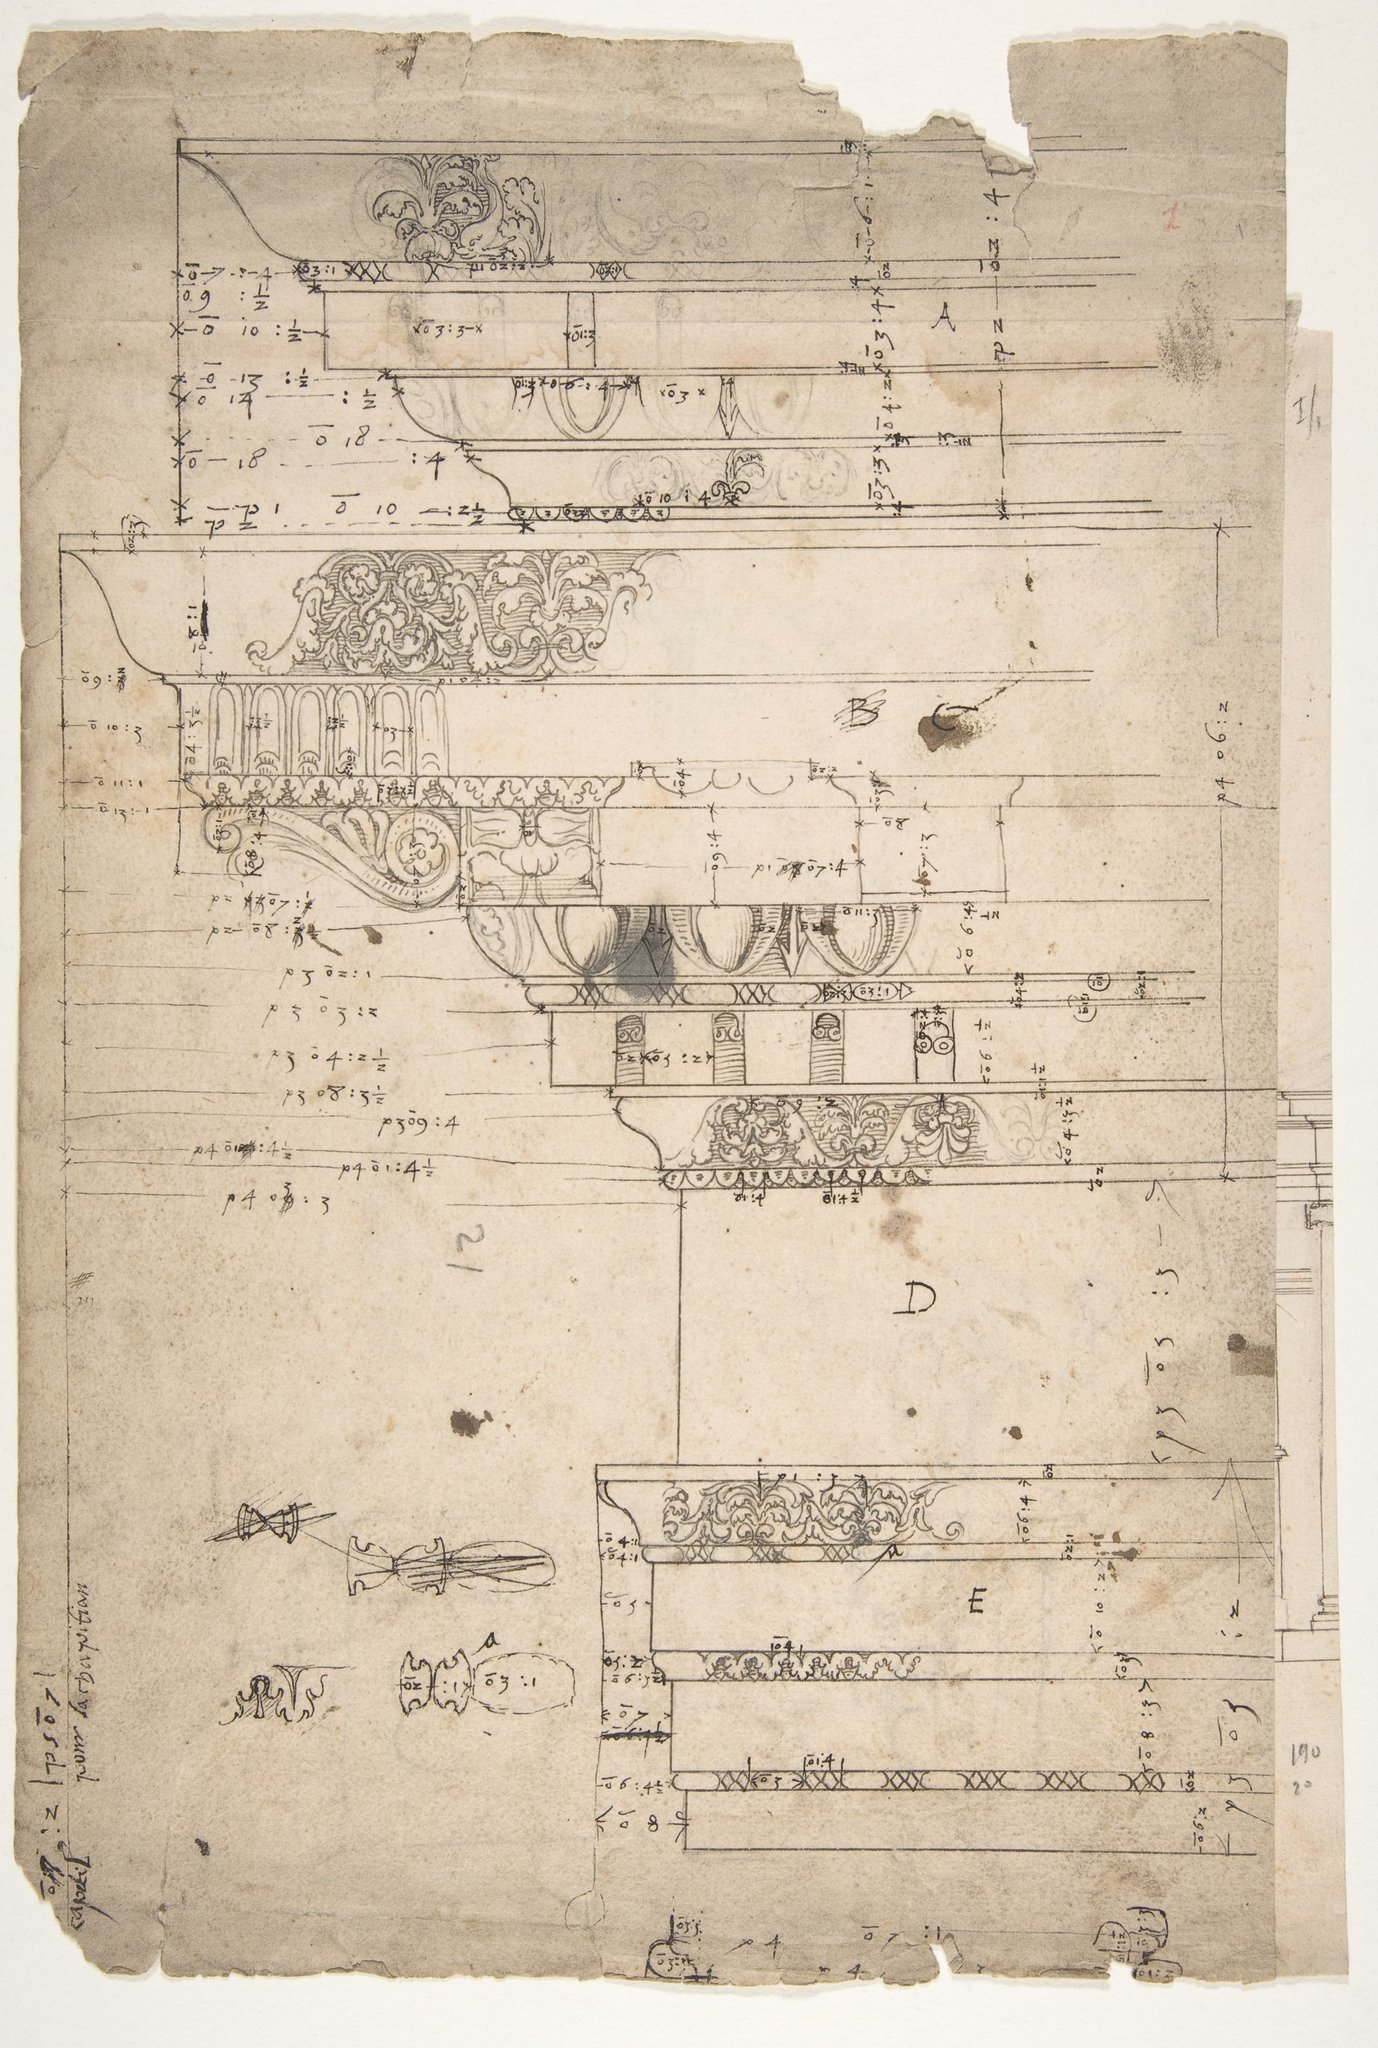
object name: collection ornament architecture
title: Forum of Nerva, entablature, elevation; cornice, elevation (recto) Forum of Nerva, architrave panel, ceiling plan, Corinthian, capital (verso)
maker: anonymous, french, 16th century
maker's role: draftsman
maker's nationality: french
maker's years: 1500-1600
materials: chalk, ink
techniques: incising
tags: architecture